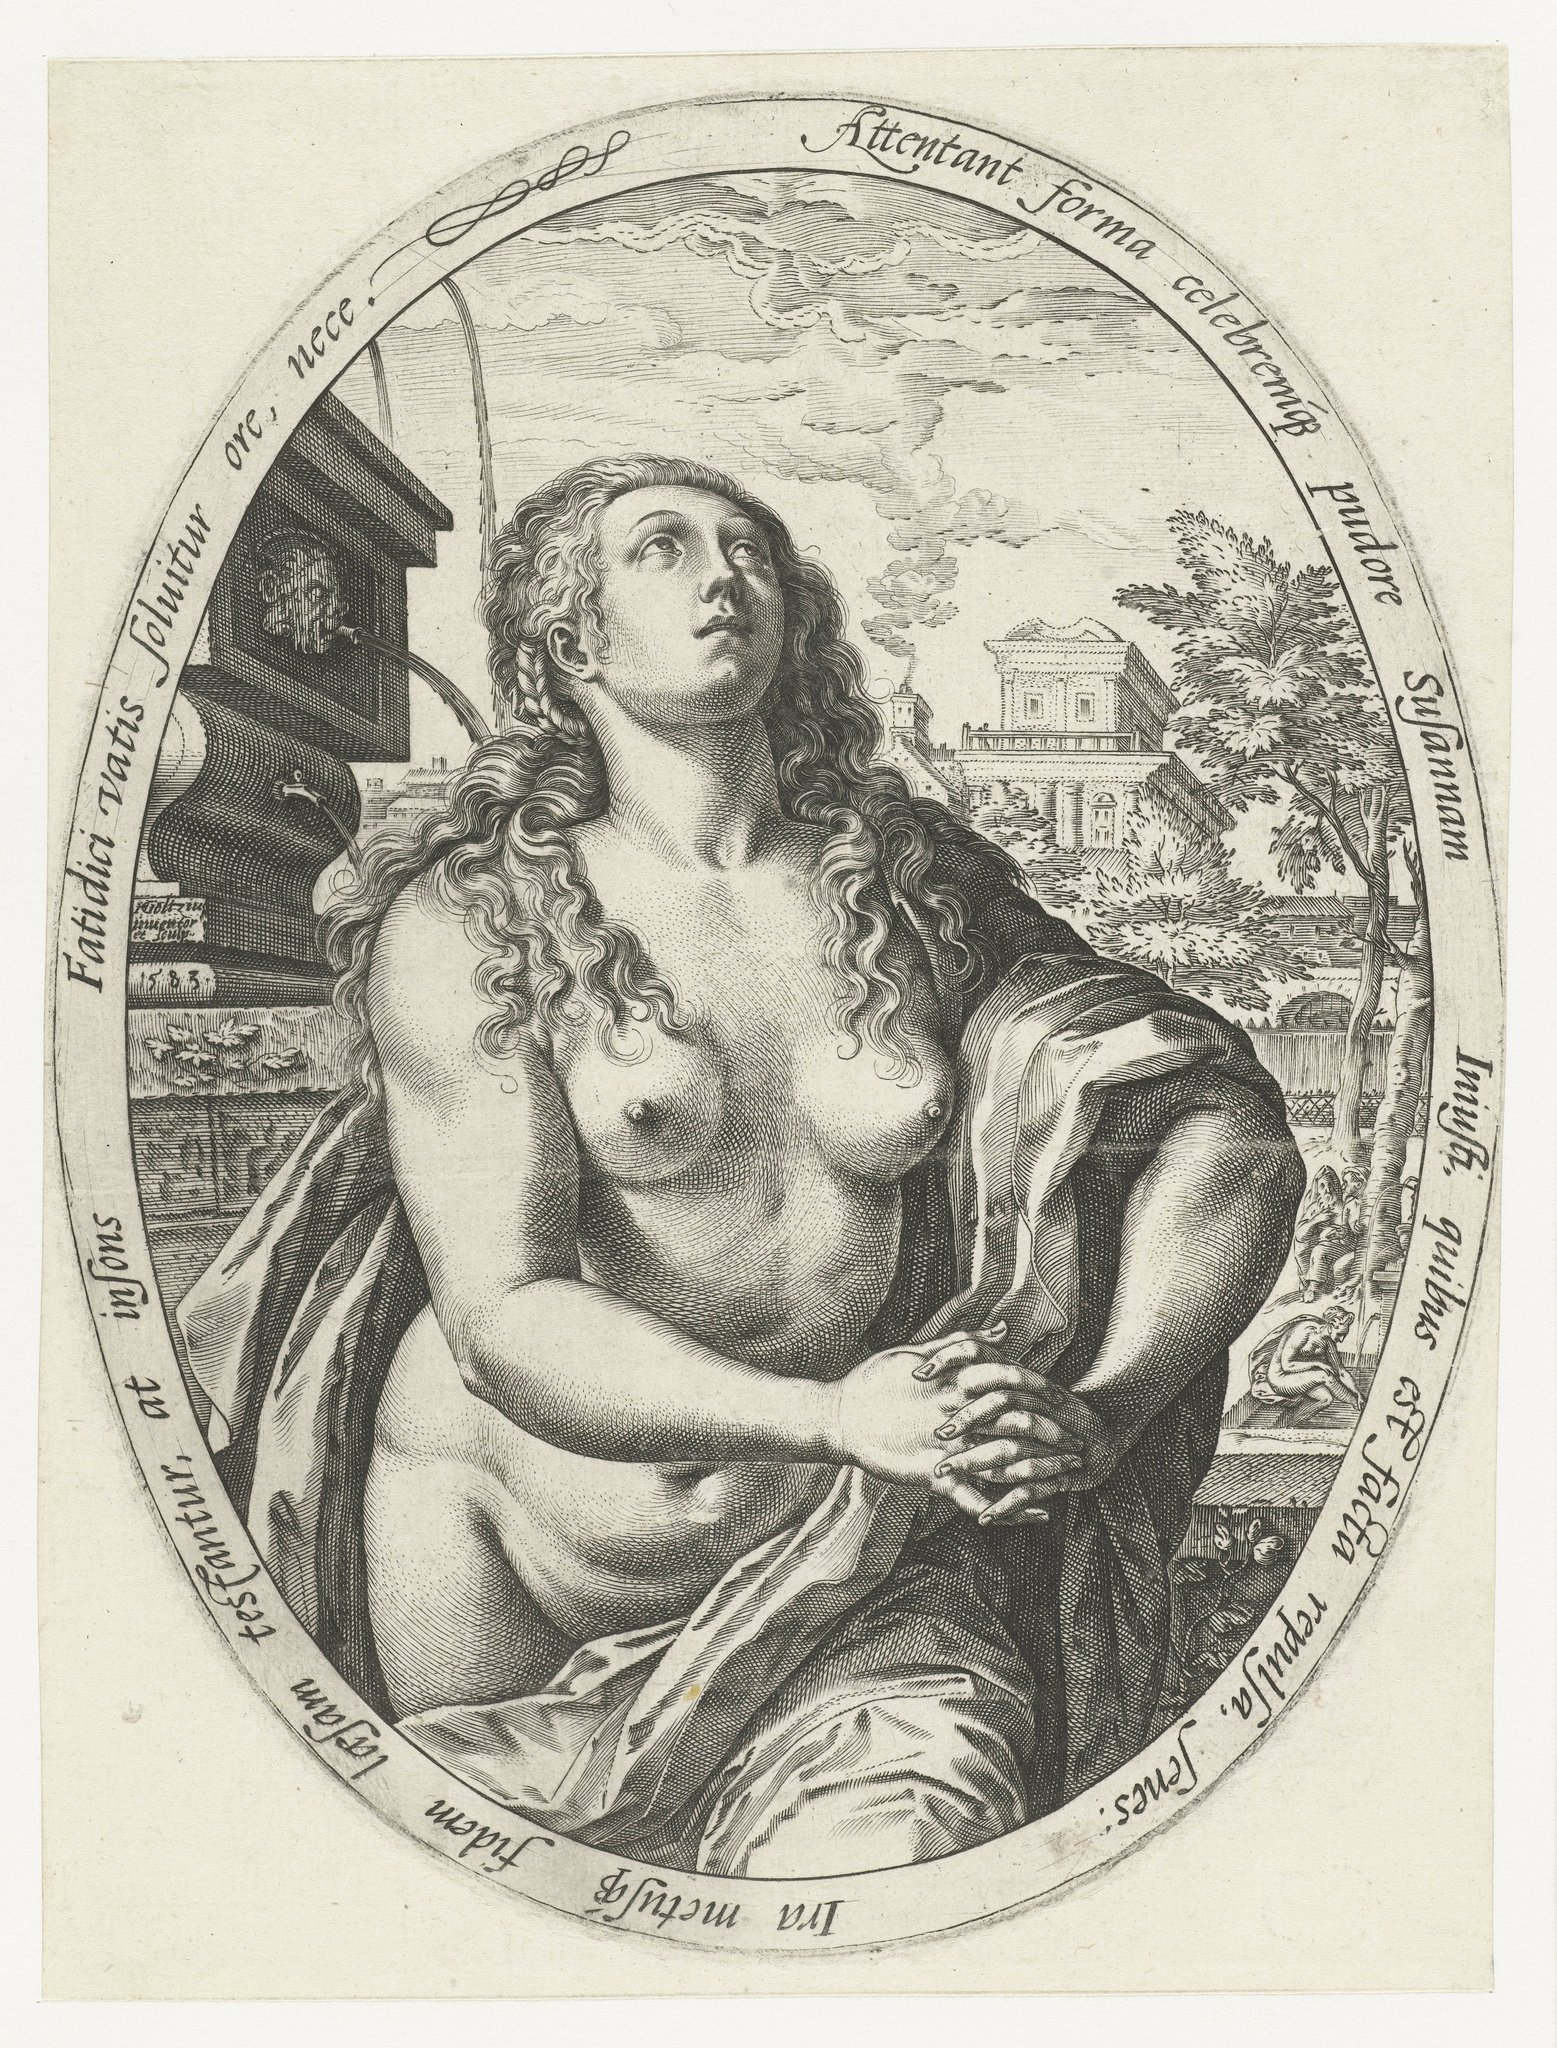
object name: print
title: Susanna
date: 1583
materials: paper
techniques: engraving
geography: haarlem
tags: the elders spying upon susanna, female persons from the old testament (with name) (not in biblical context)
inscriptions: signature and date: ‘HGoltzius inuentor et sculp.’, collector's mark: Lugt 240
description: Susanna, ten halven lijve afgebeeld in een ovaal. De handen gevouwen, blik gericht naar de hemel. Op de achtergrond rechts is Susanna badend weergegeven, terwijl ze bespied wordt door de ouderlingen. Rondom het ovaal een Latijnse tekst.